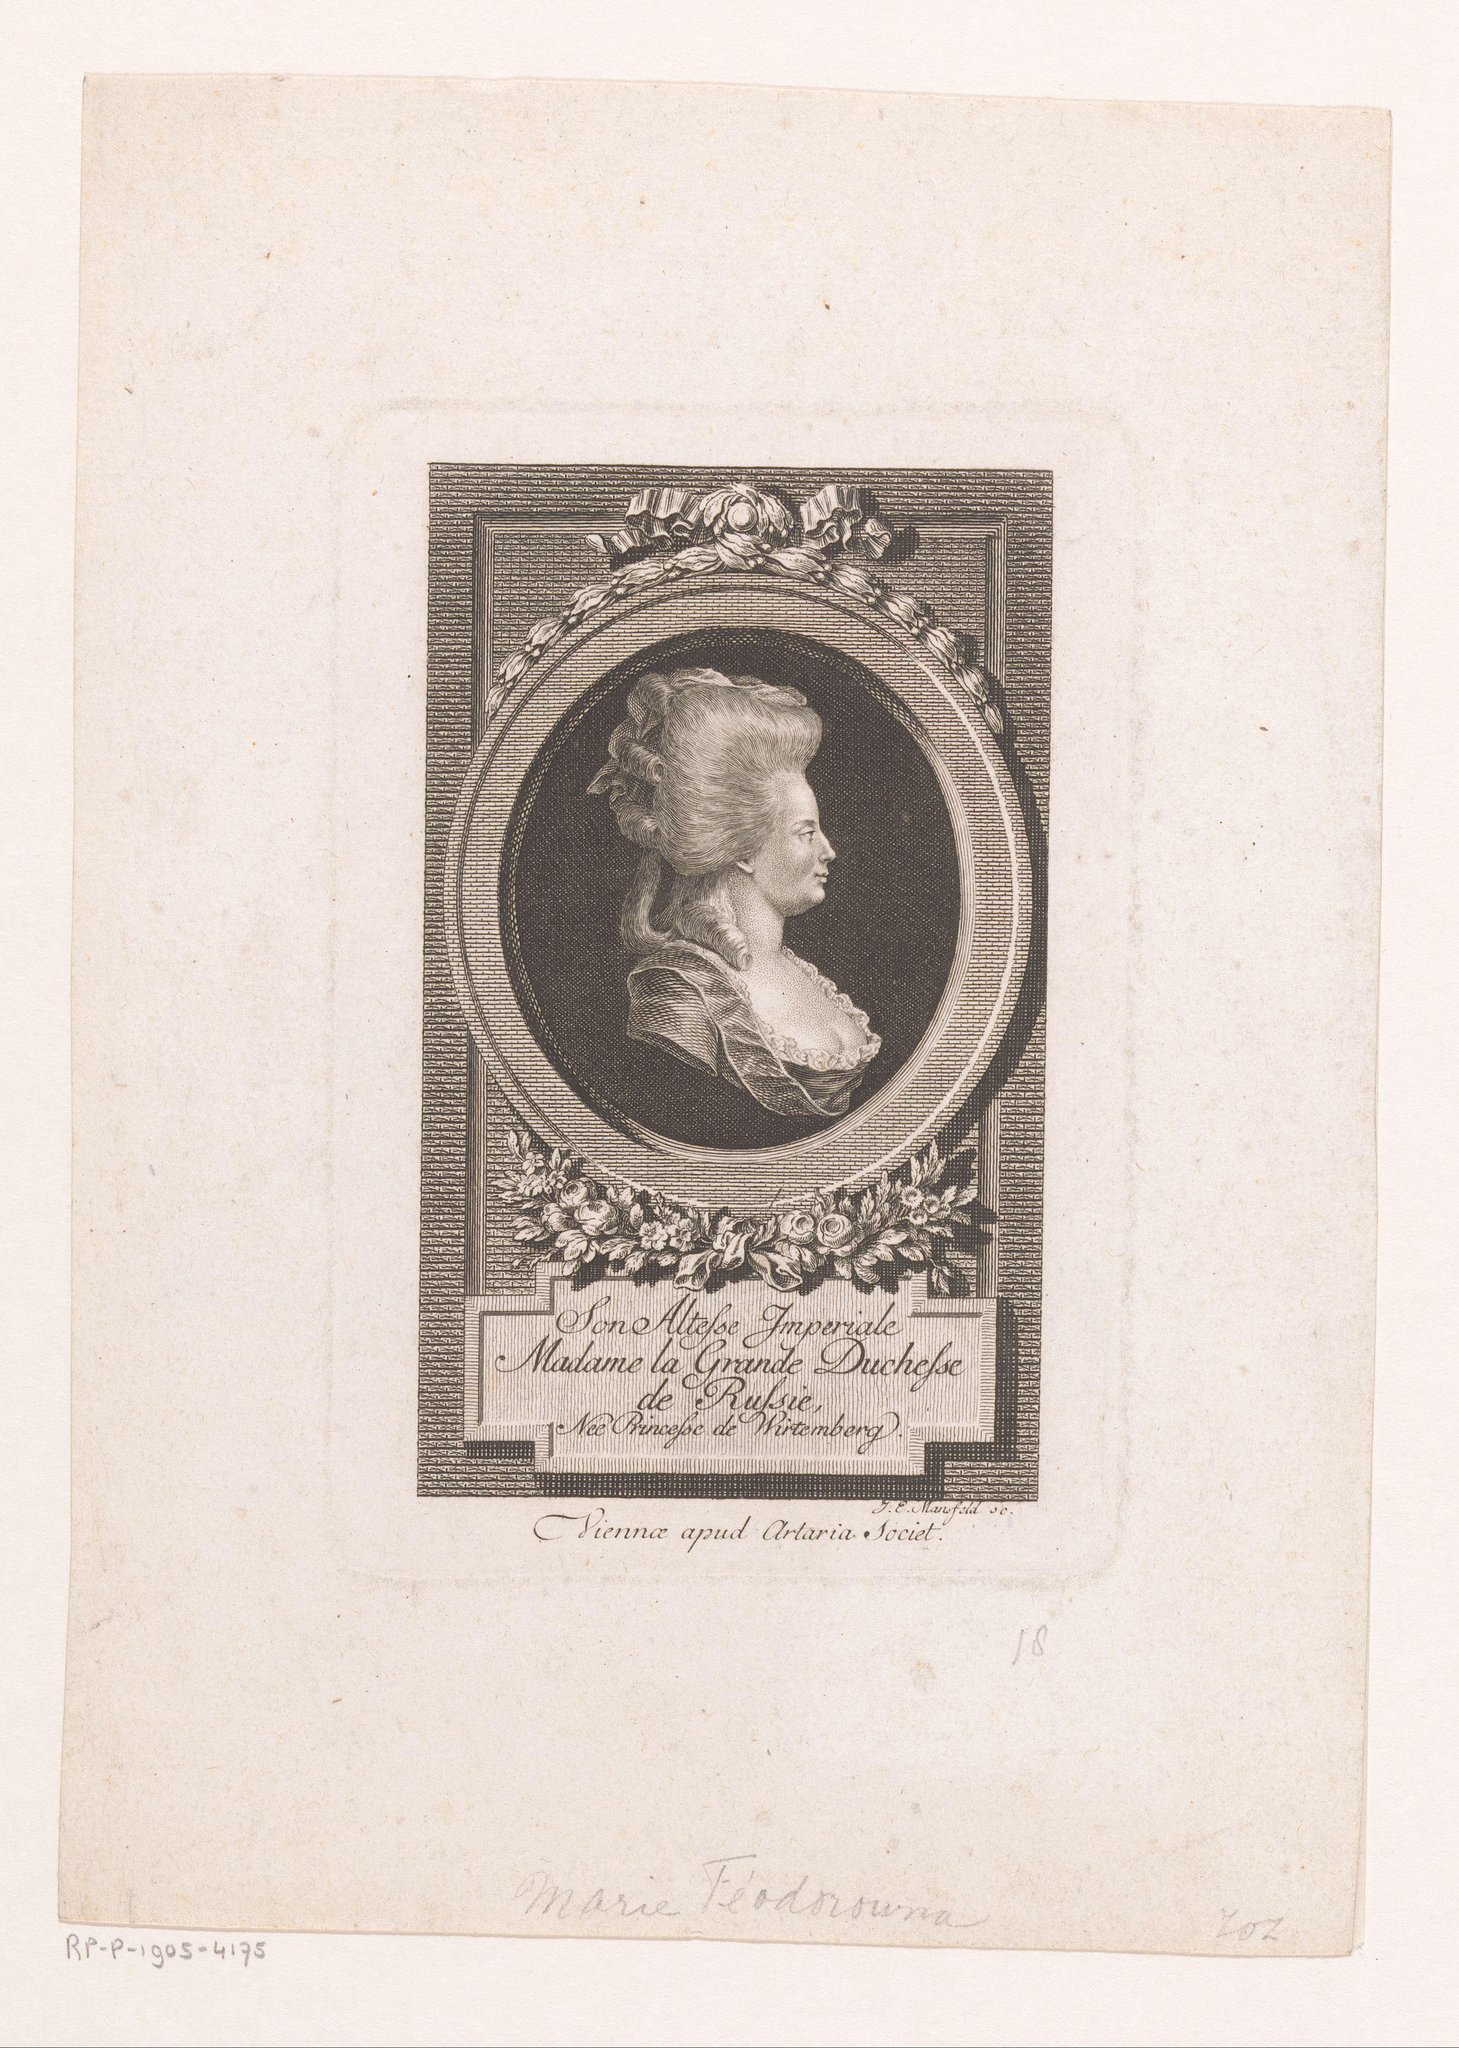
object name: print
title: Portret van Maria Fjodorovna I, keizerin van Rusland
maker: johann ernst mansfeld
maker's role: print maker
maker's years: 1739-1796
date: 1749-1796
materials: paper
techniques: engraving, etching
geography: vienna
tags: maria féodorowna, historical persons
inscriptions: collector's mark: Lugt 2228